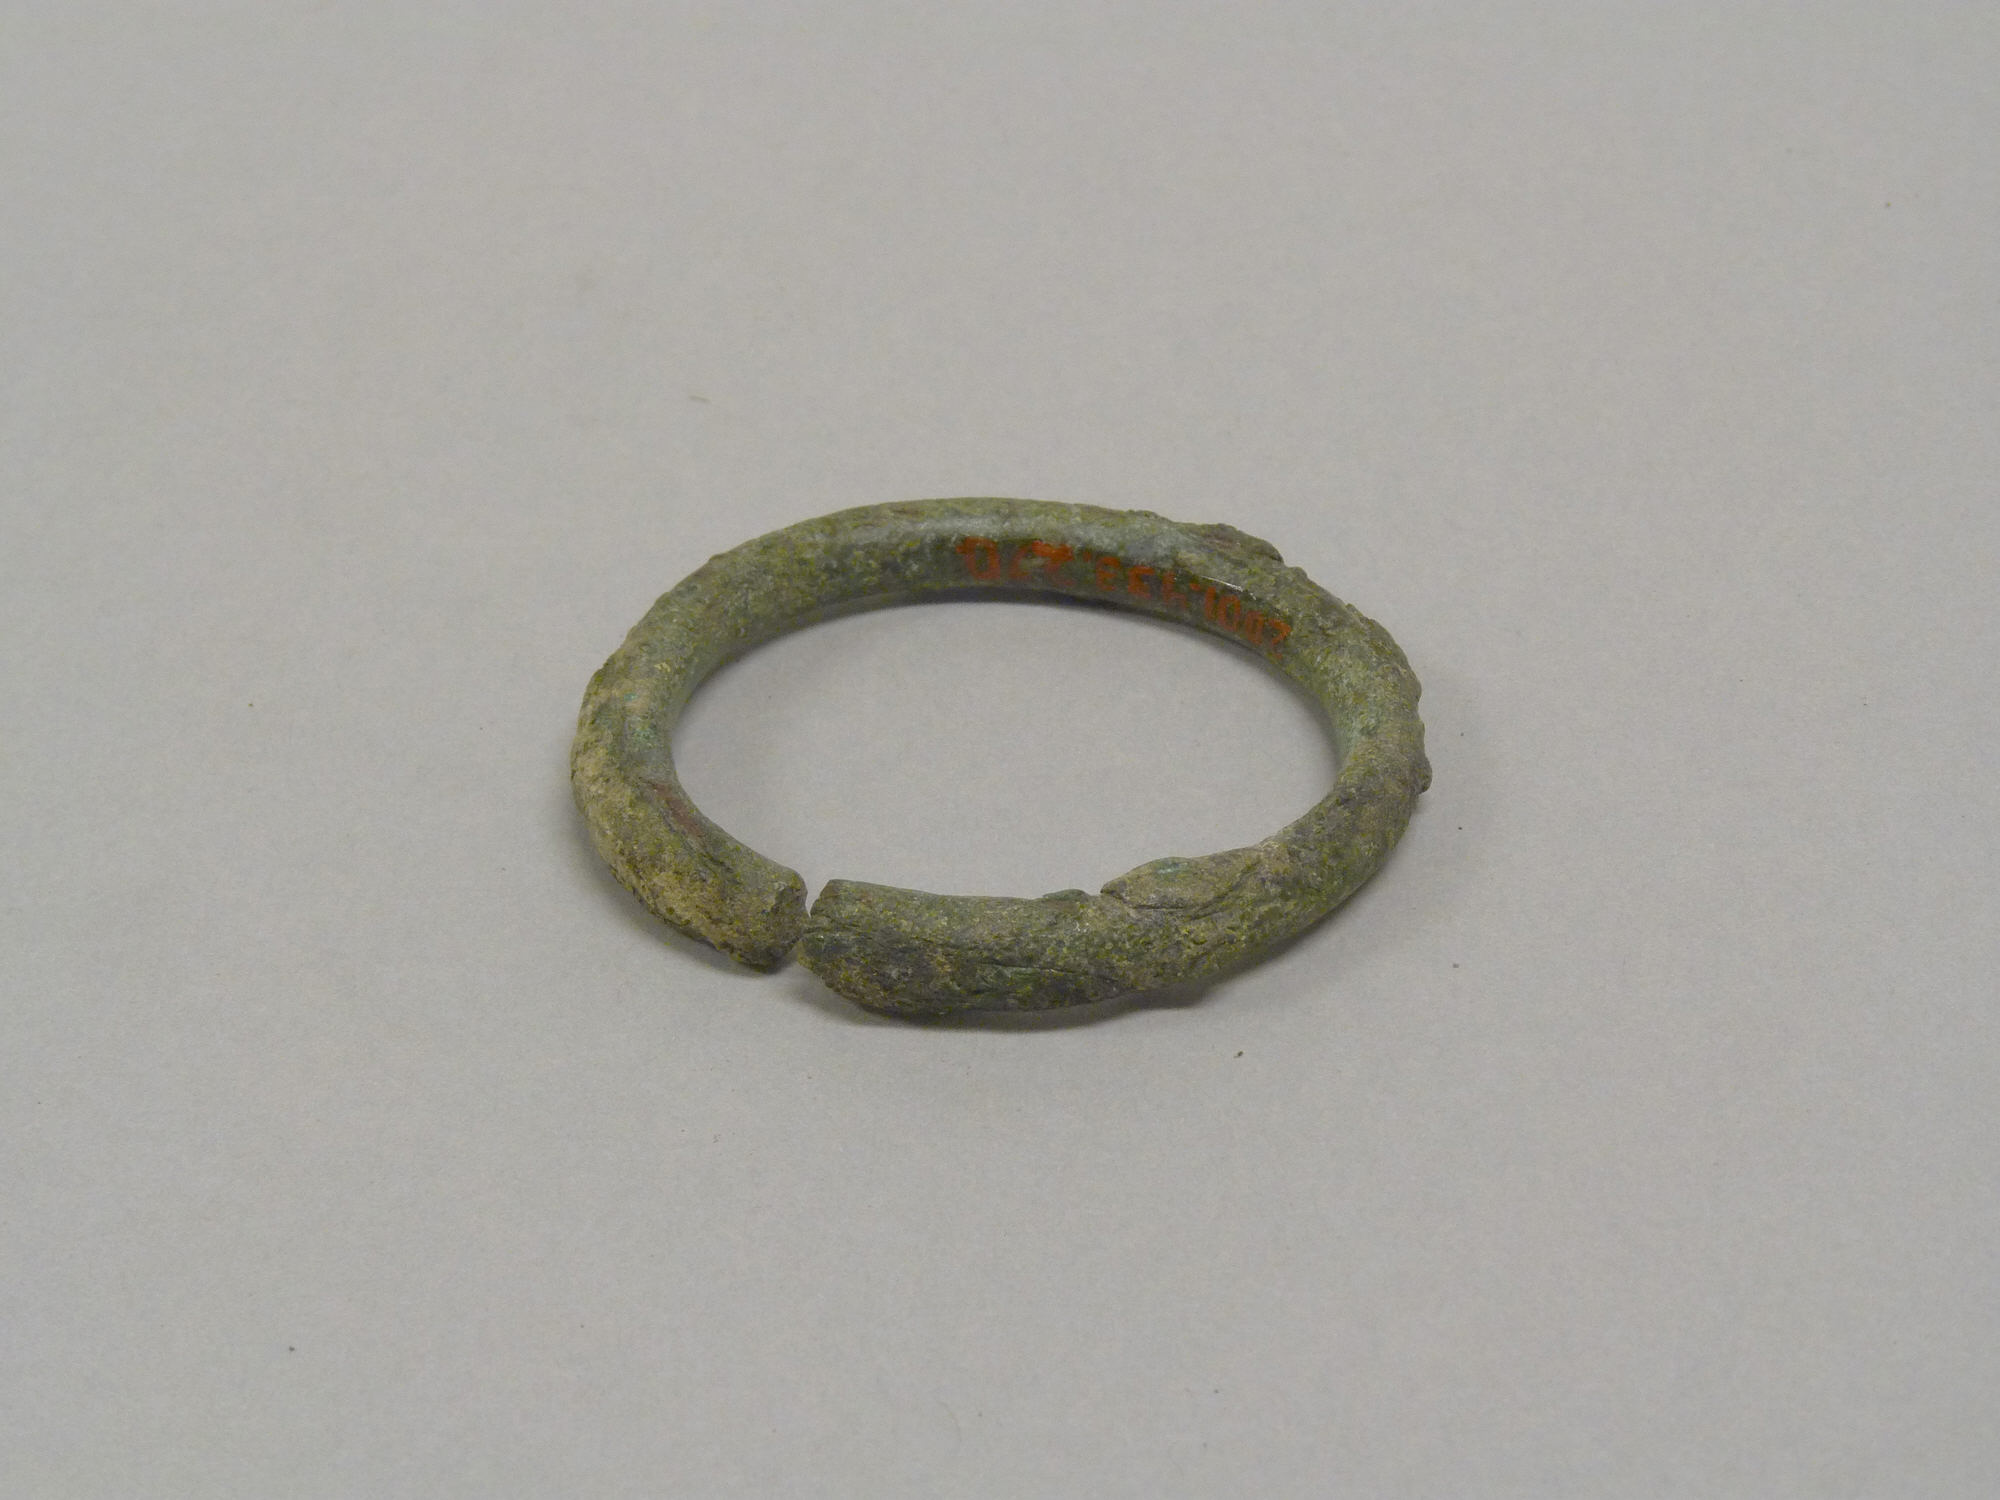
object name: solid undecorated bangle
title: Solid Undecorated Bangle with Flat Surface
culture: thai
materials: bronze